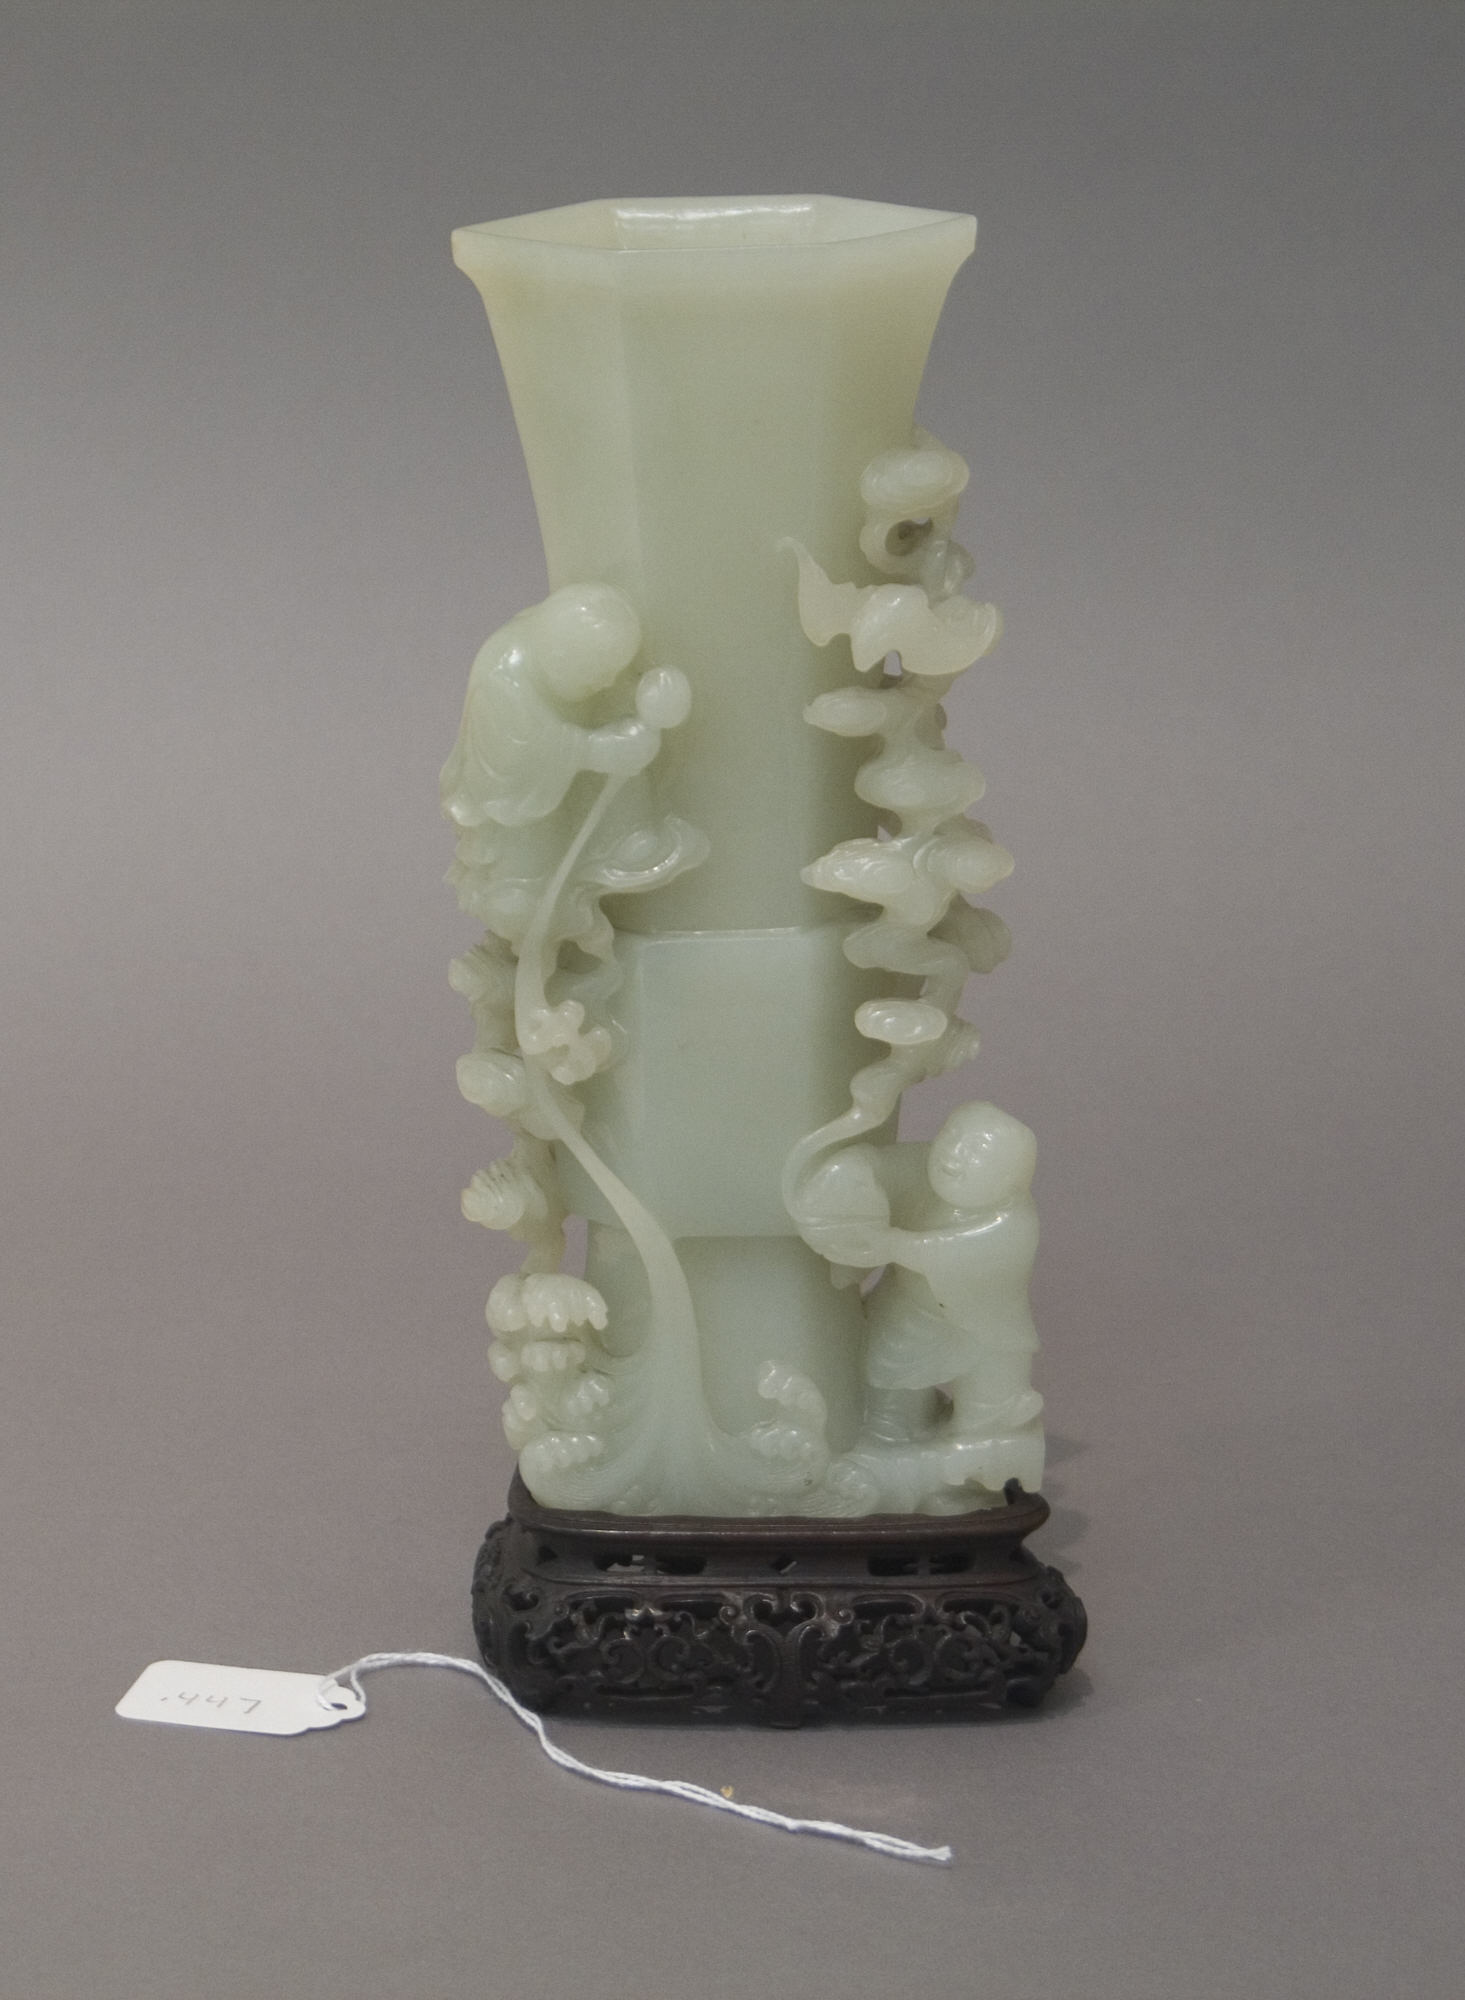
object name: vase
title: Hexagonal vase with immortals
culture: chinese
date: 1701-1800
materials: jade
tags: men